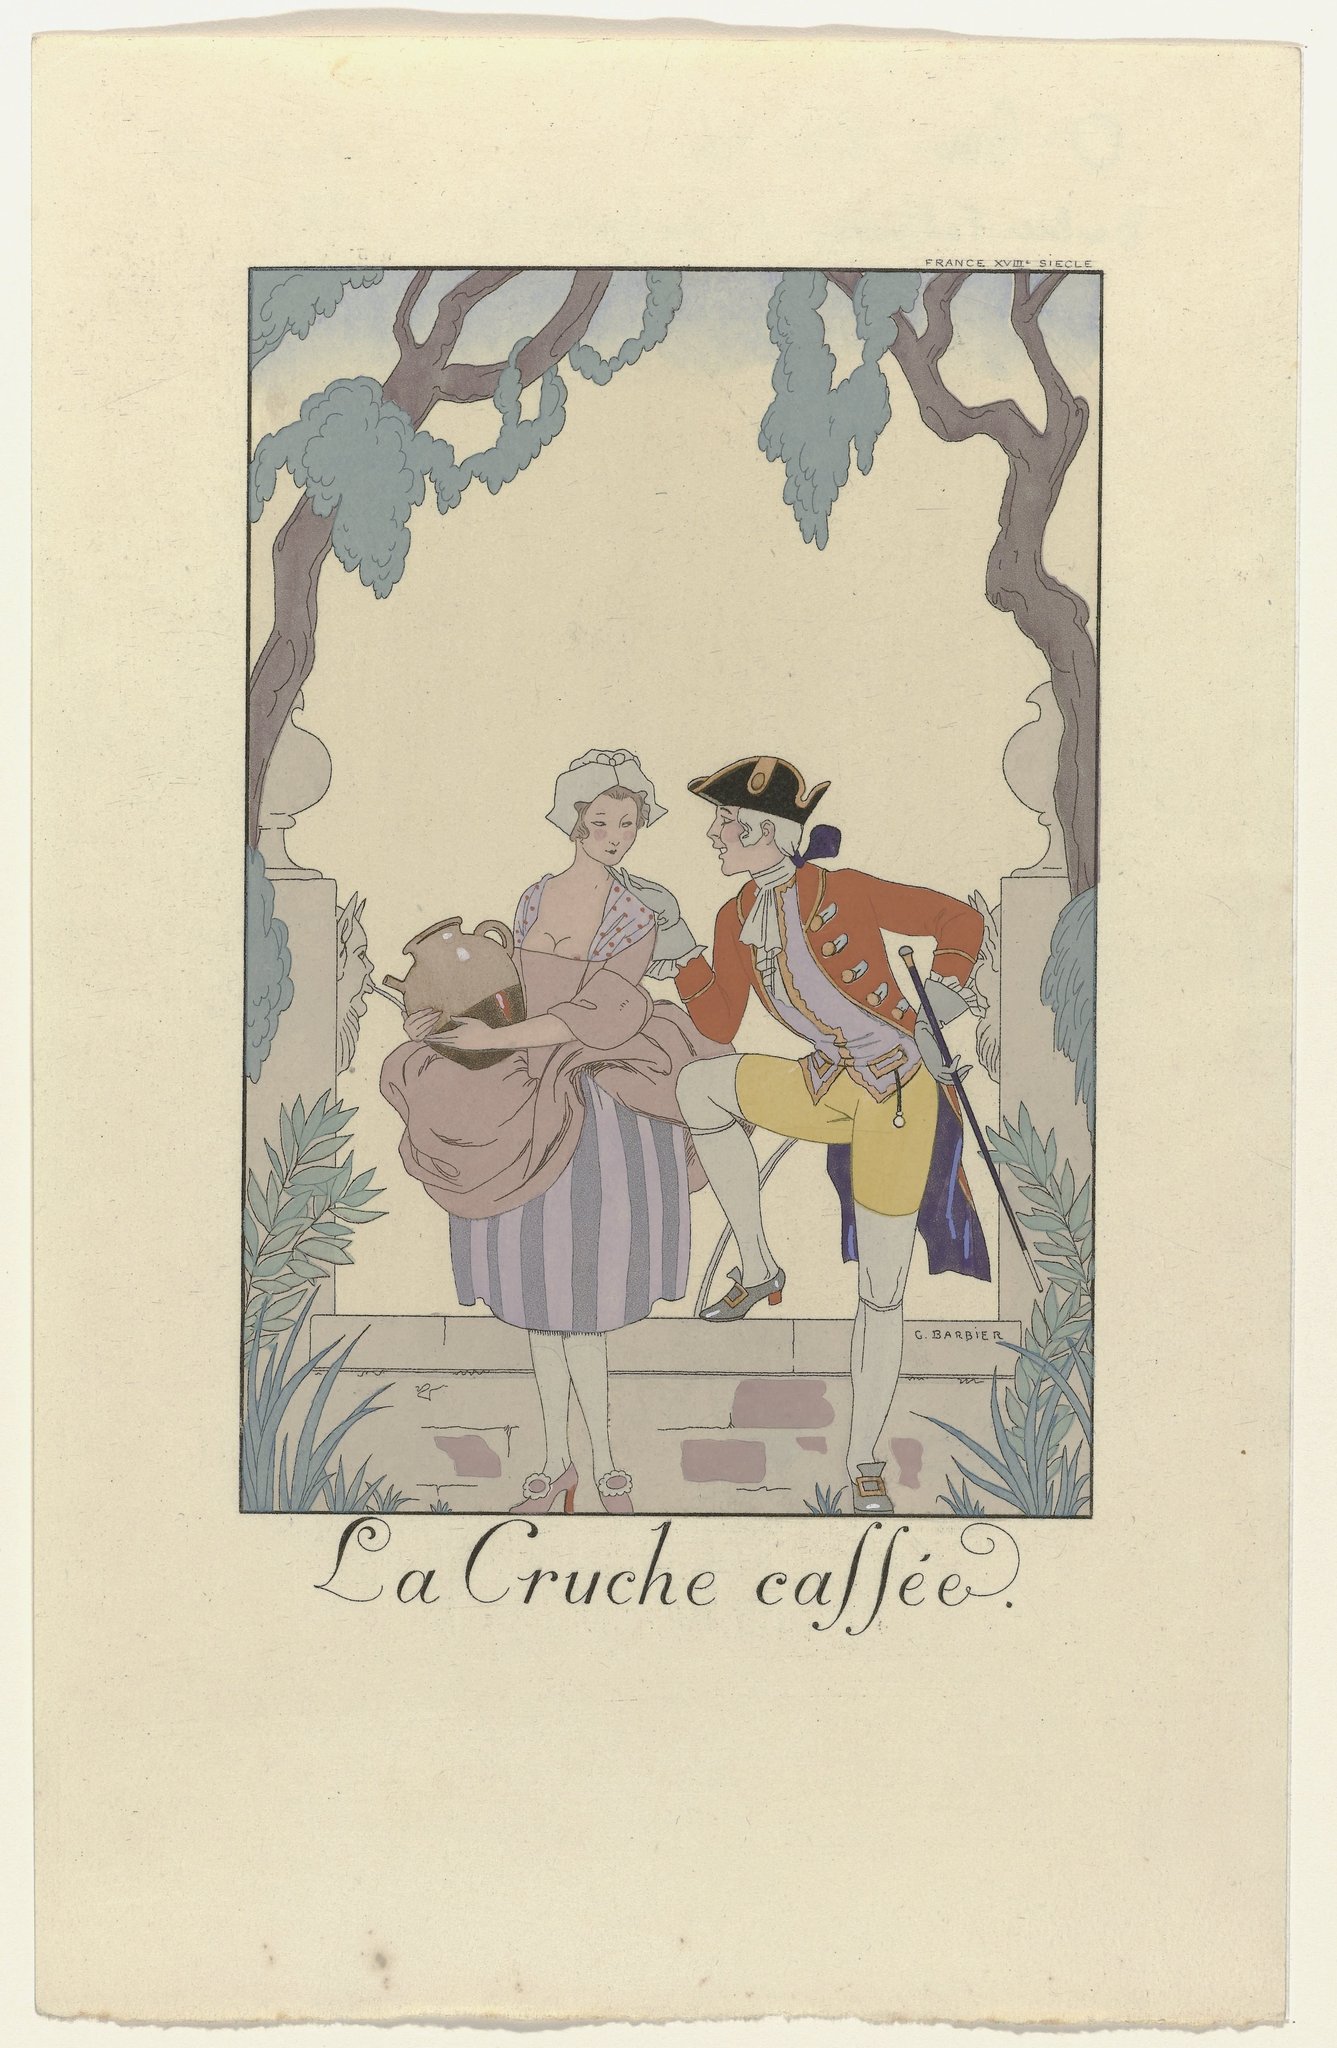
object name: fashion print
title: Falbalas et Fanfreluches pour 1925 : La Cruche caffée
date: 1925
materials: paper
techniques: engraving, hand coloring, pochoir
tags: historical costume (+ variant), coat (+ men's clothes), jar, jug (used as drinking-vessel), head-gear: hat (+ men's clothes), head-gear: cap (+ women's clothes), fashion plates, dress, gown (+ women's clothes), shoes, sandals (+ men's clothes), trousers, breeches, etc. (breeches) (+ men's clothes), walking-stick, staff, cane (+ men's clothes), lovers; courting, flirting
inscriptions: inscription: ‘FRANCE XVIIIe SIECLE’, title: ‘La Cruche caffée.’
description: Een theatrale versie van een ontmoeting bij een fontein in Frankrijk in de achttiende eeuw. Zij draagt een 'robe paysanne' met decolleté en korte onderrok. Hij draagt een te korte en strakke mantel en kniebroek. De gebarsten waterkruik moet de deugdzaamheid van de jonge vrouw symboliseren. De prent maakt deel uit van de almanak 'Falbalas et Fanfreluches pour 1925' van George Barbier.